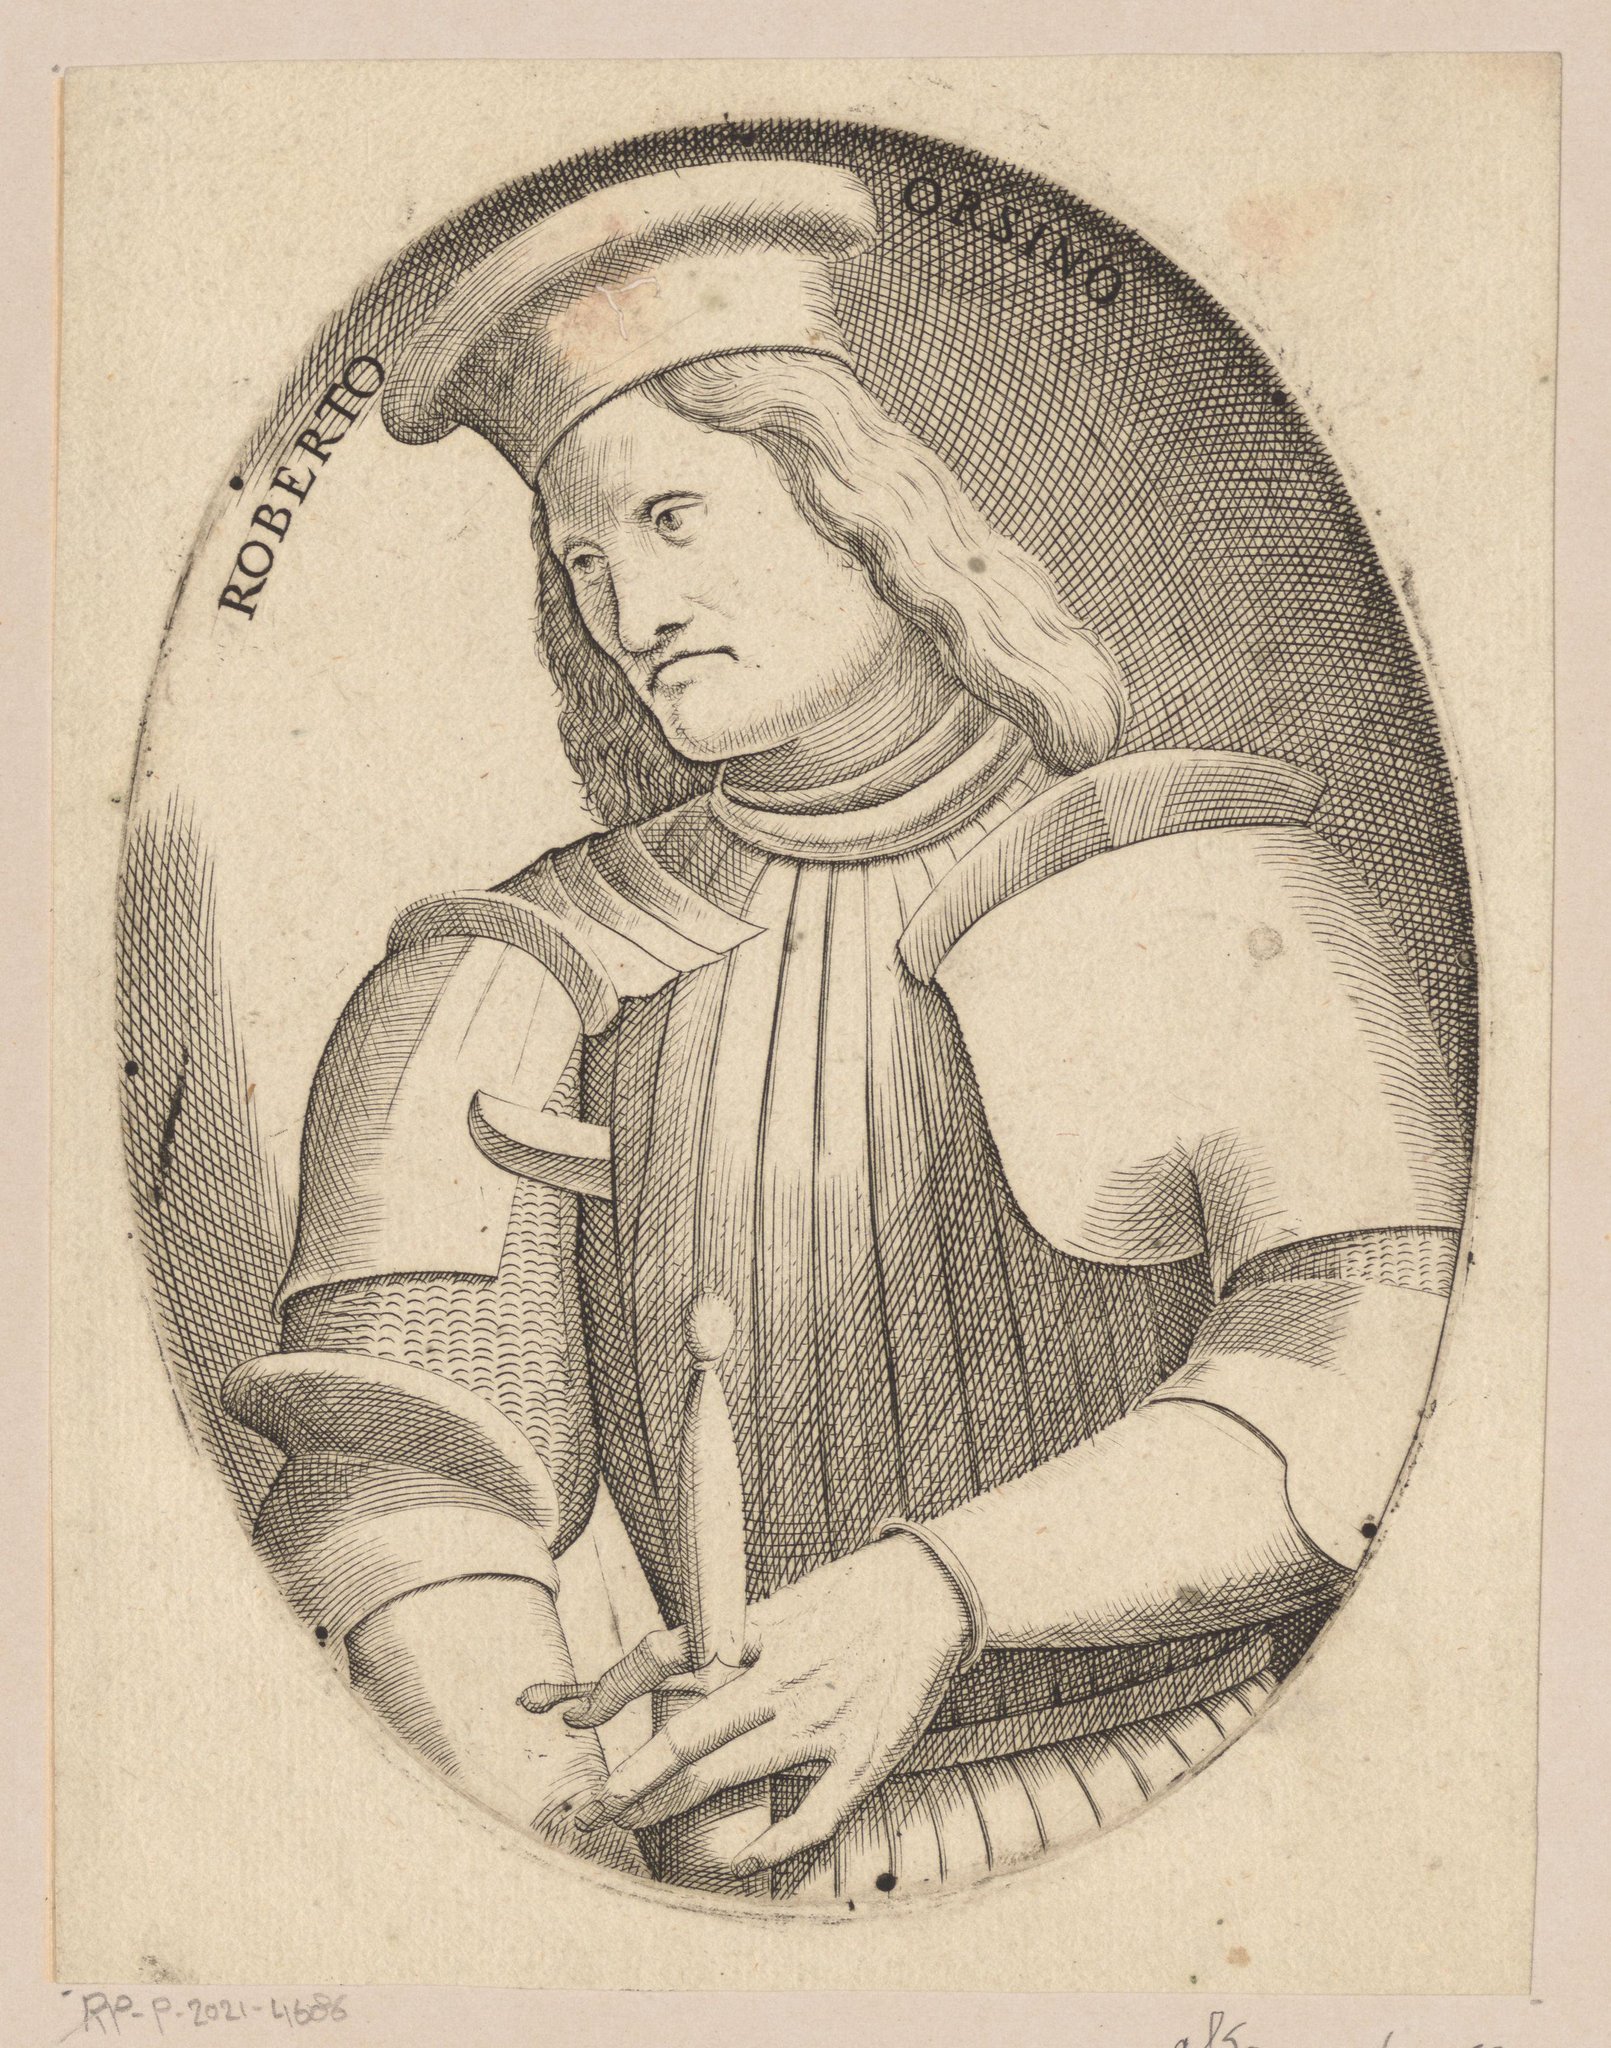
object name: print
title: Portret van Roberto graaf van Tagliacozzo Orsini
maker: Anonymous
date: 1565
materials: paper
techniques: engraving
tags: historical persons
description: Prent met omlijsting gebruikt in: Sansovino, Francesco. L'Historia di Casa Orsina di Francesco Sansovino. Venetië: Filippo en Bernardino Stagnino, 1565.